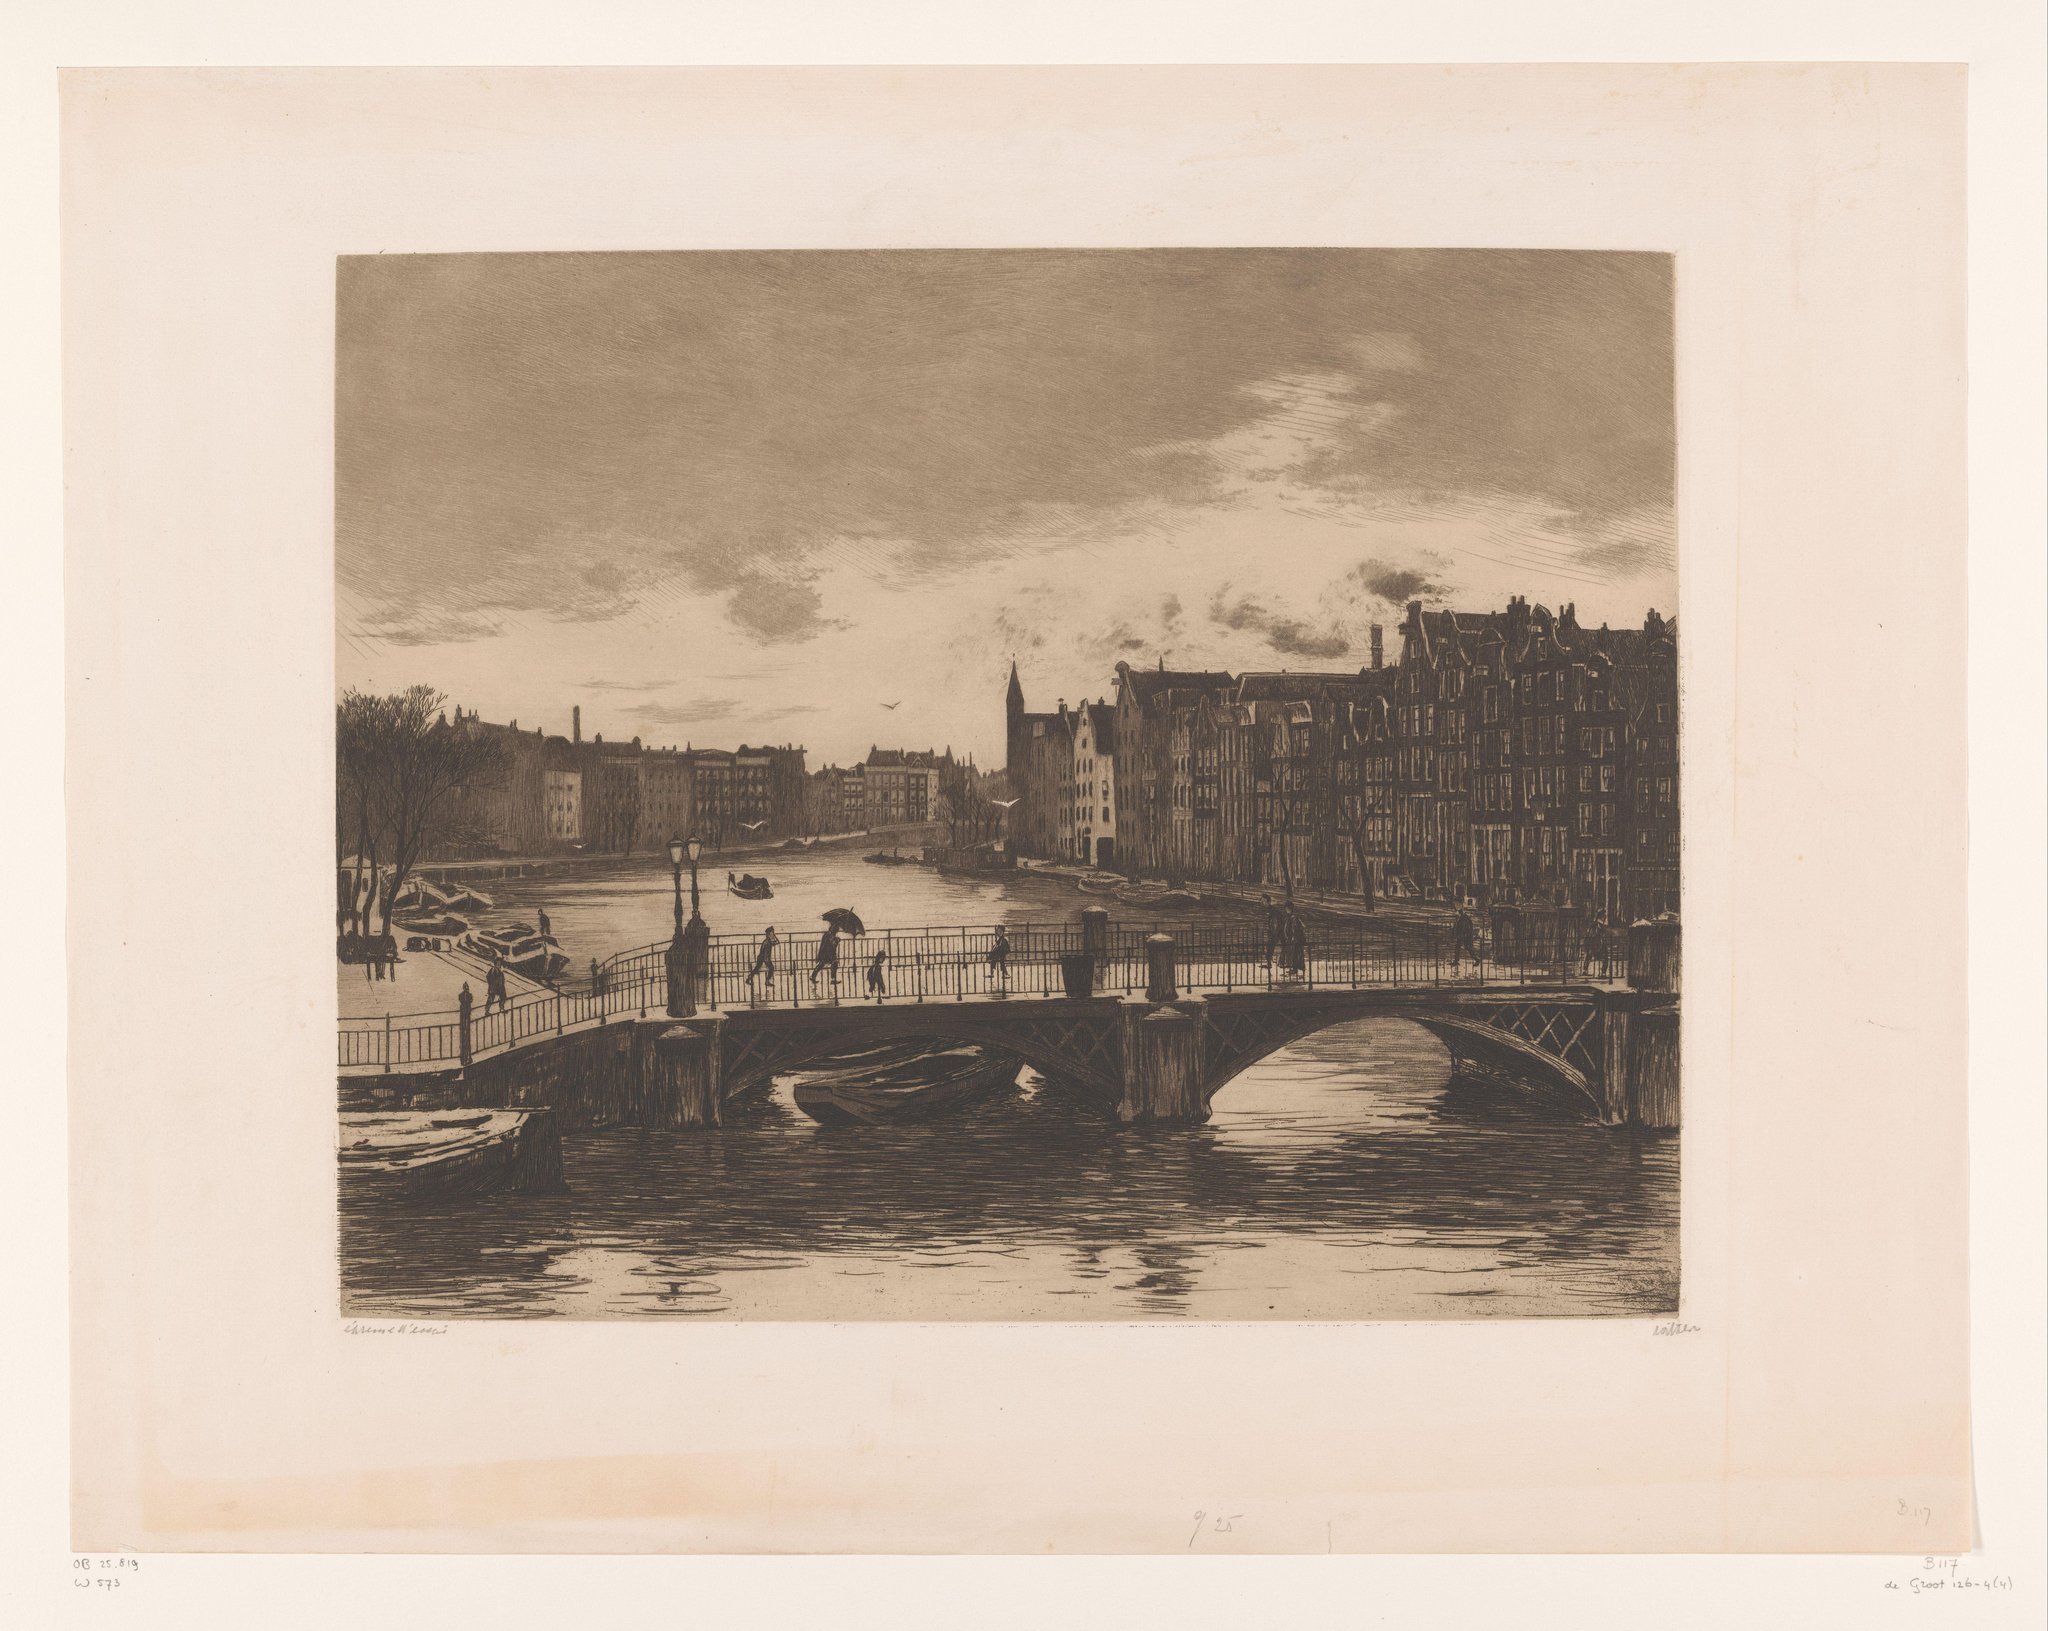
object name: print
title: Gezicht op de Binnen-Amstel en de Halvemaansteegbrug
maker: willem witsen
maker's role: draughtsman, painter, print maker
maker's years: 1860-1923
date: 1906-1907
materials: paper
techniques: aquatint, etching, intaglio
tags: urban housing, city-view in general; 'veduta', bridge in city across river, canal, etc.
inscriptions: annotation: ‘épreuve d'essai’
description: Gezicht vanuit de ramen aan de achterzijde van het veilinghuis van Frederik Muller.